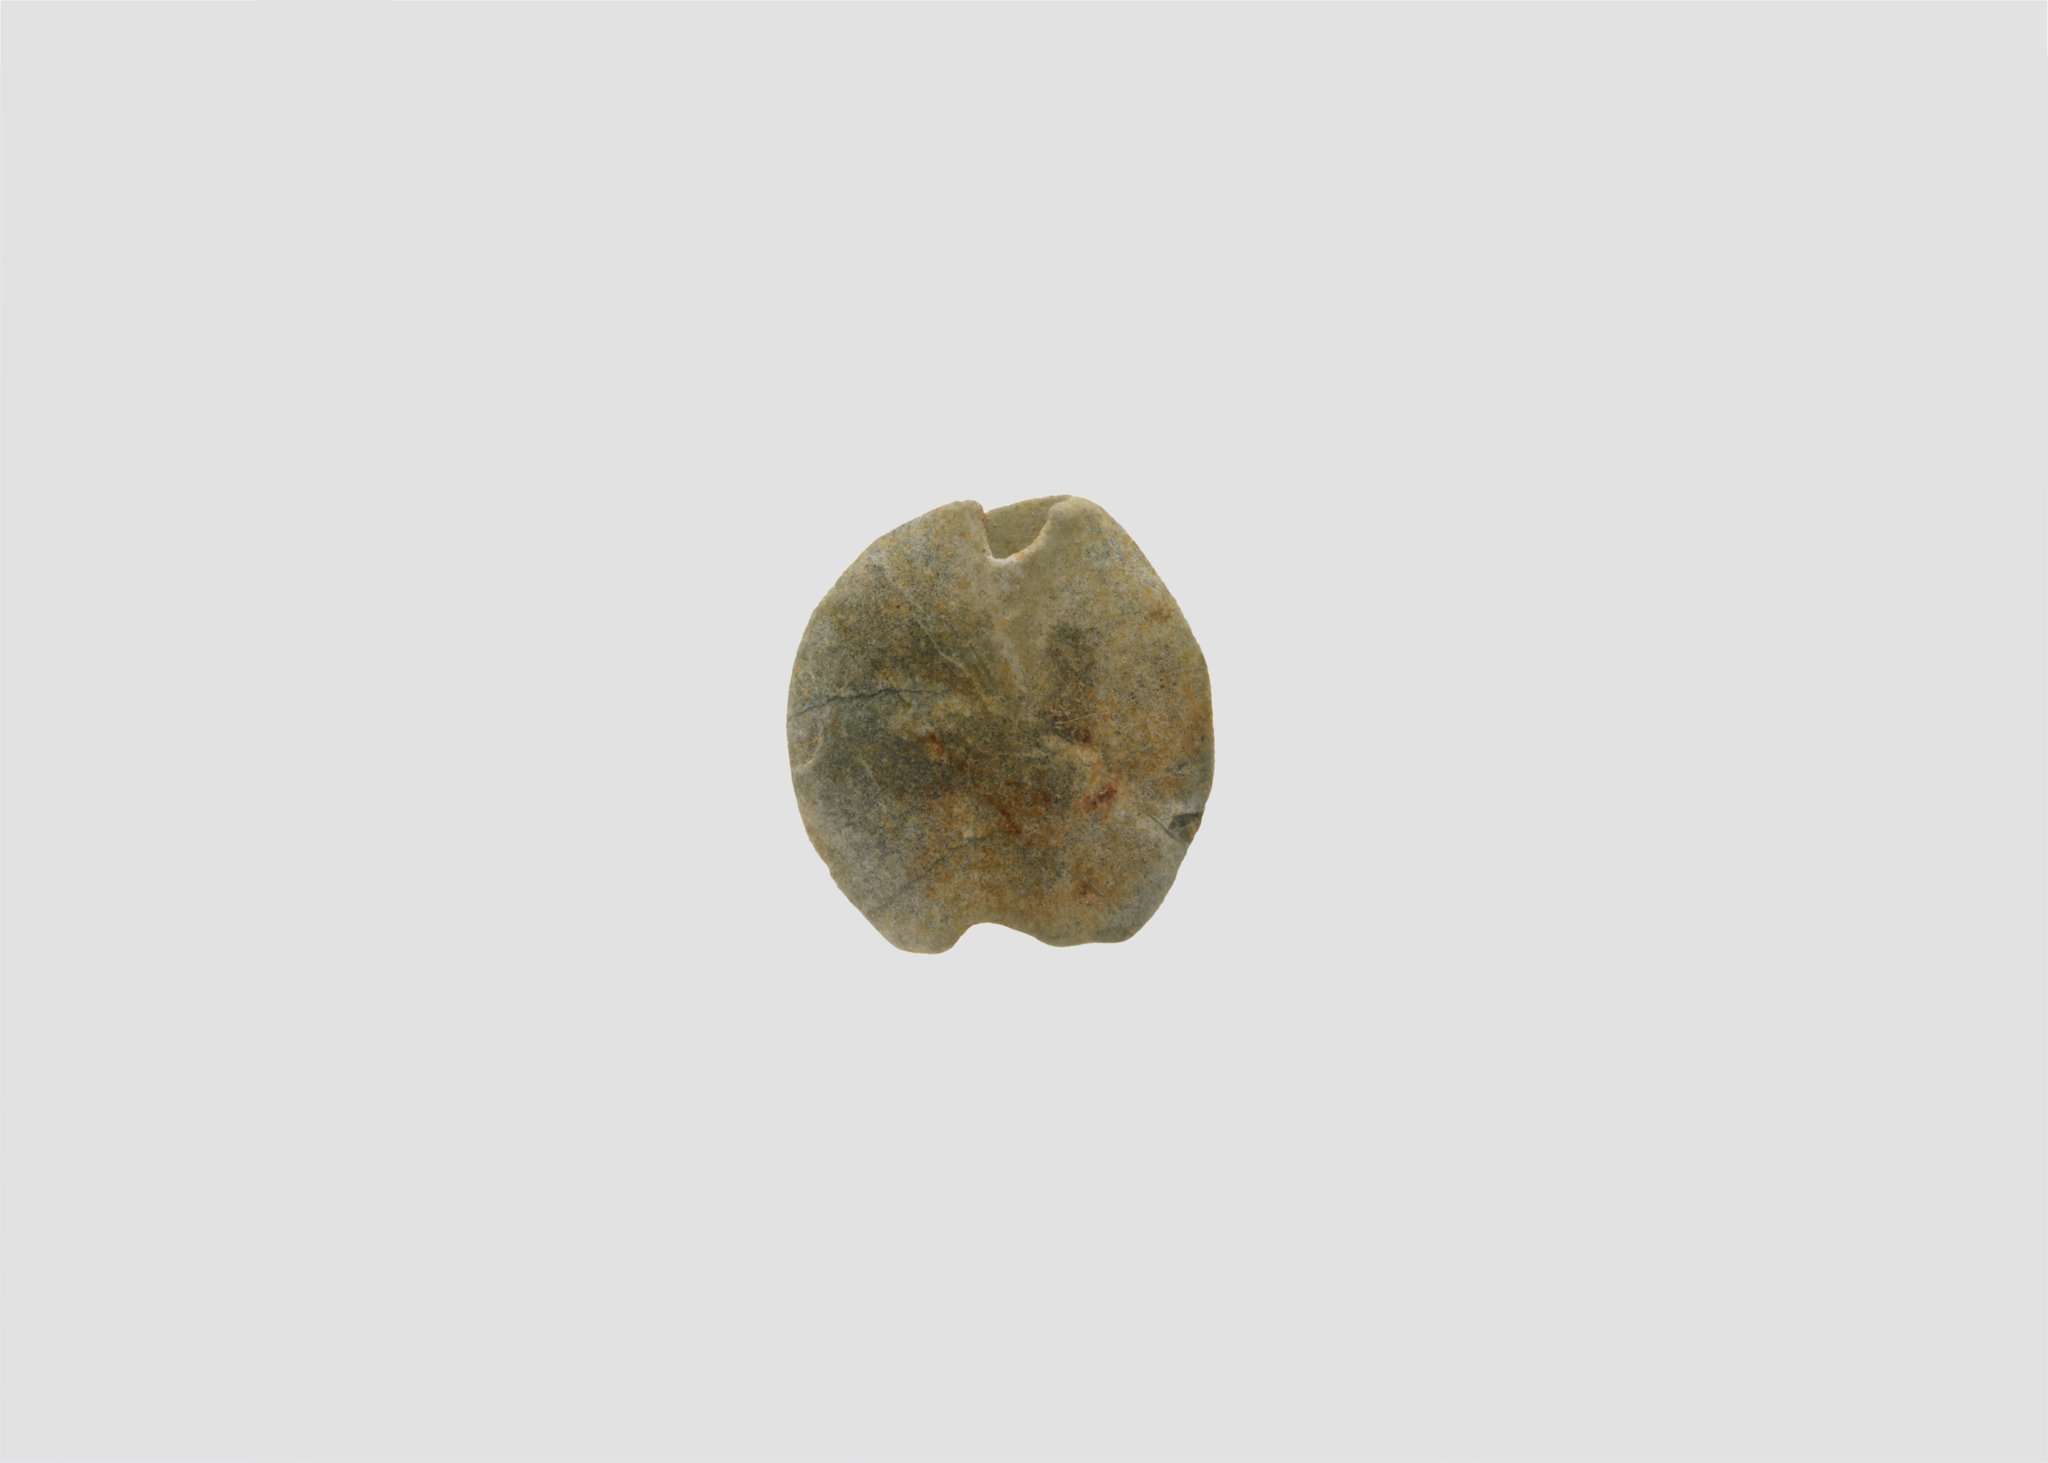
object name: bead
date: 7000-5001 BCE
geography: syria